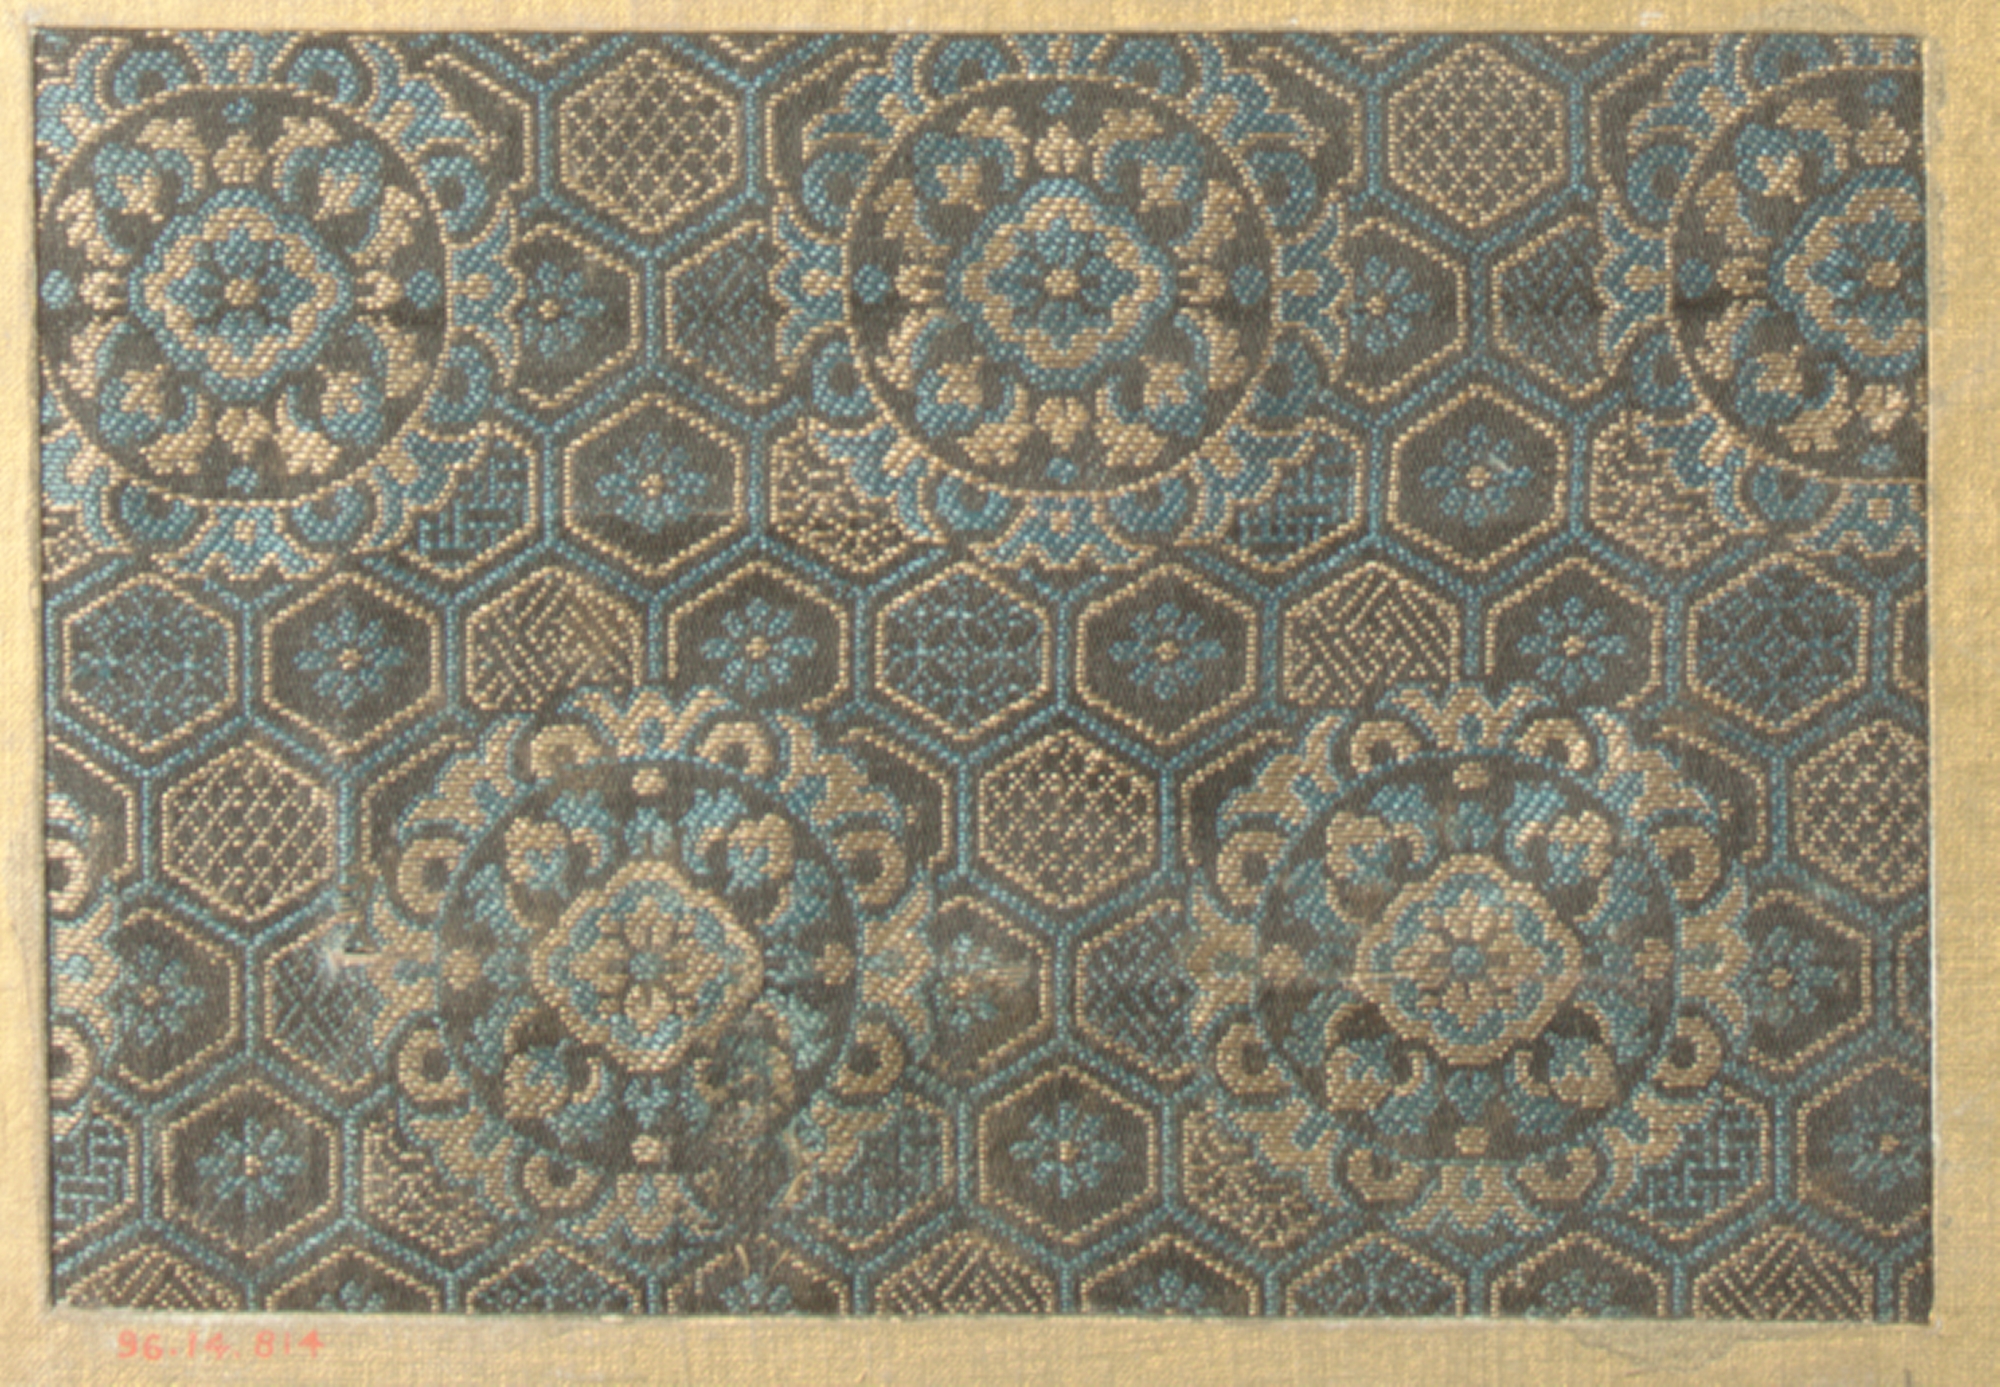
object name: piece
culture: japanese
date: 1701-1900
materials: silk